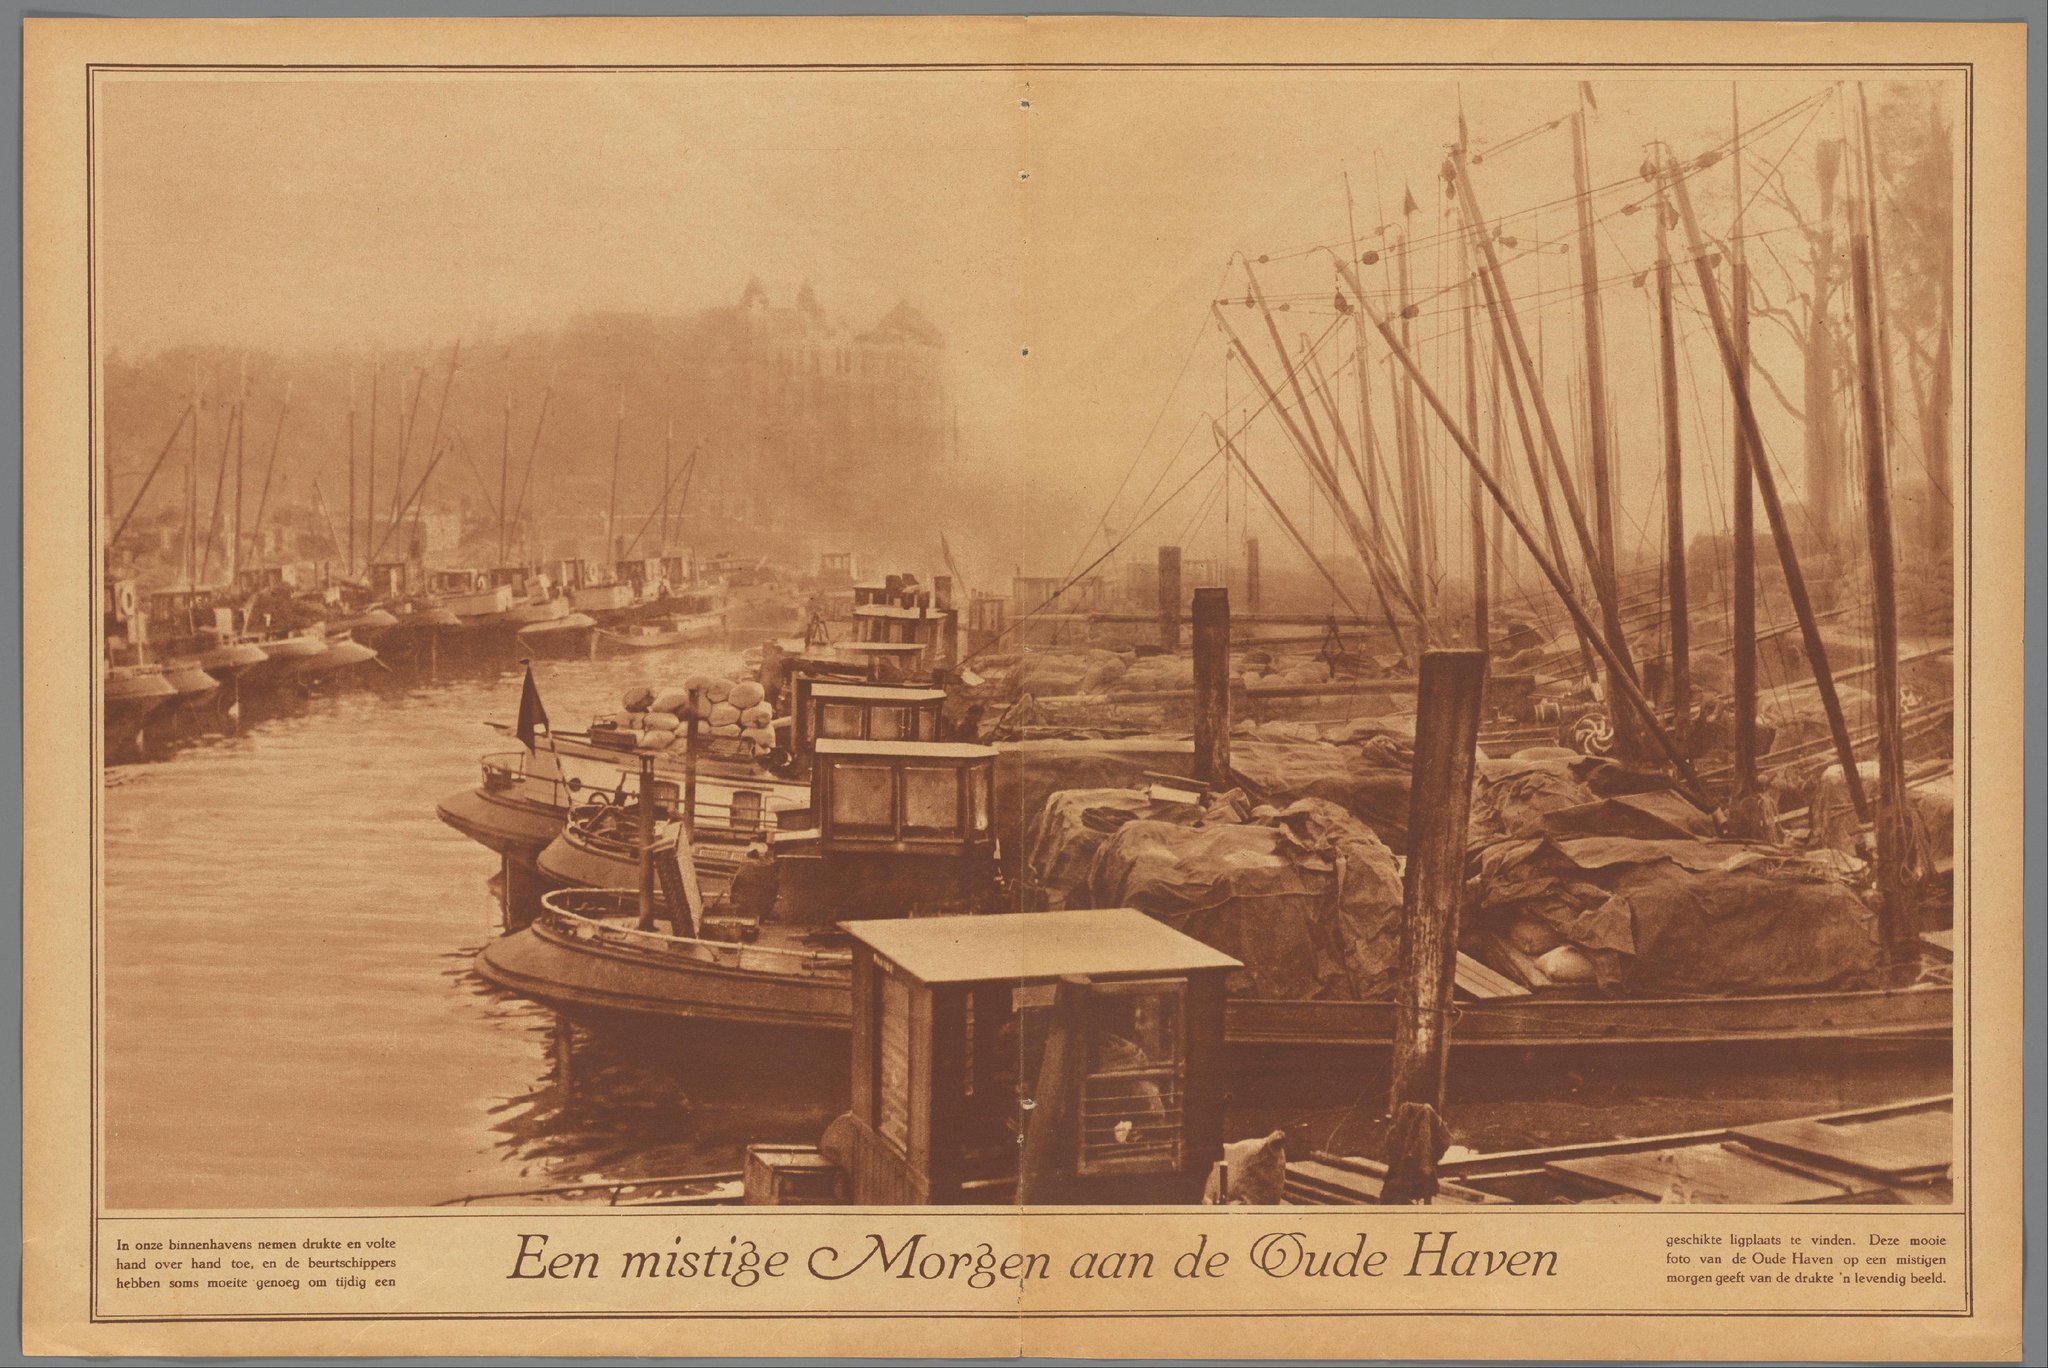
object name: photomechanical print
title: Schepen in de Oudehaven, Rotterdam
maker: Anonymous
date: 1929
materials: paper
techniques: rotogravure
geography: rotterdam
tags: harbour, ships (in general) - cc - more than one ship, rotterdam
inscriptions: inscription: ‘In onze binnenhavens (...) 'n levendig beeld.’